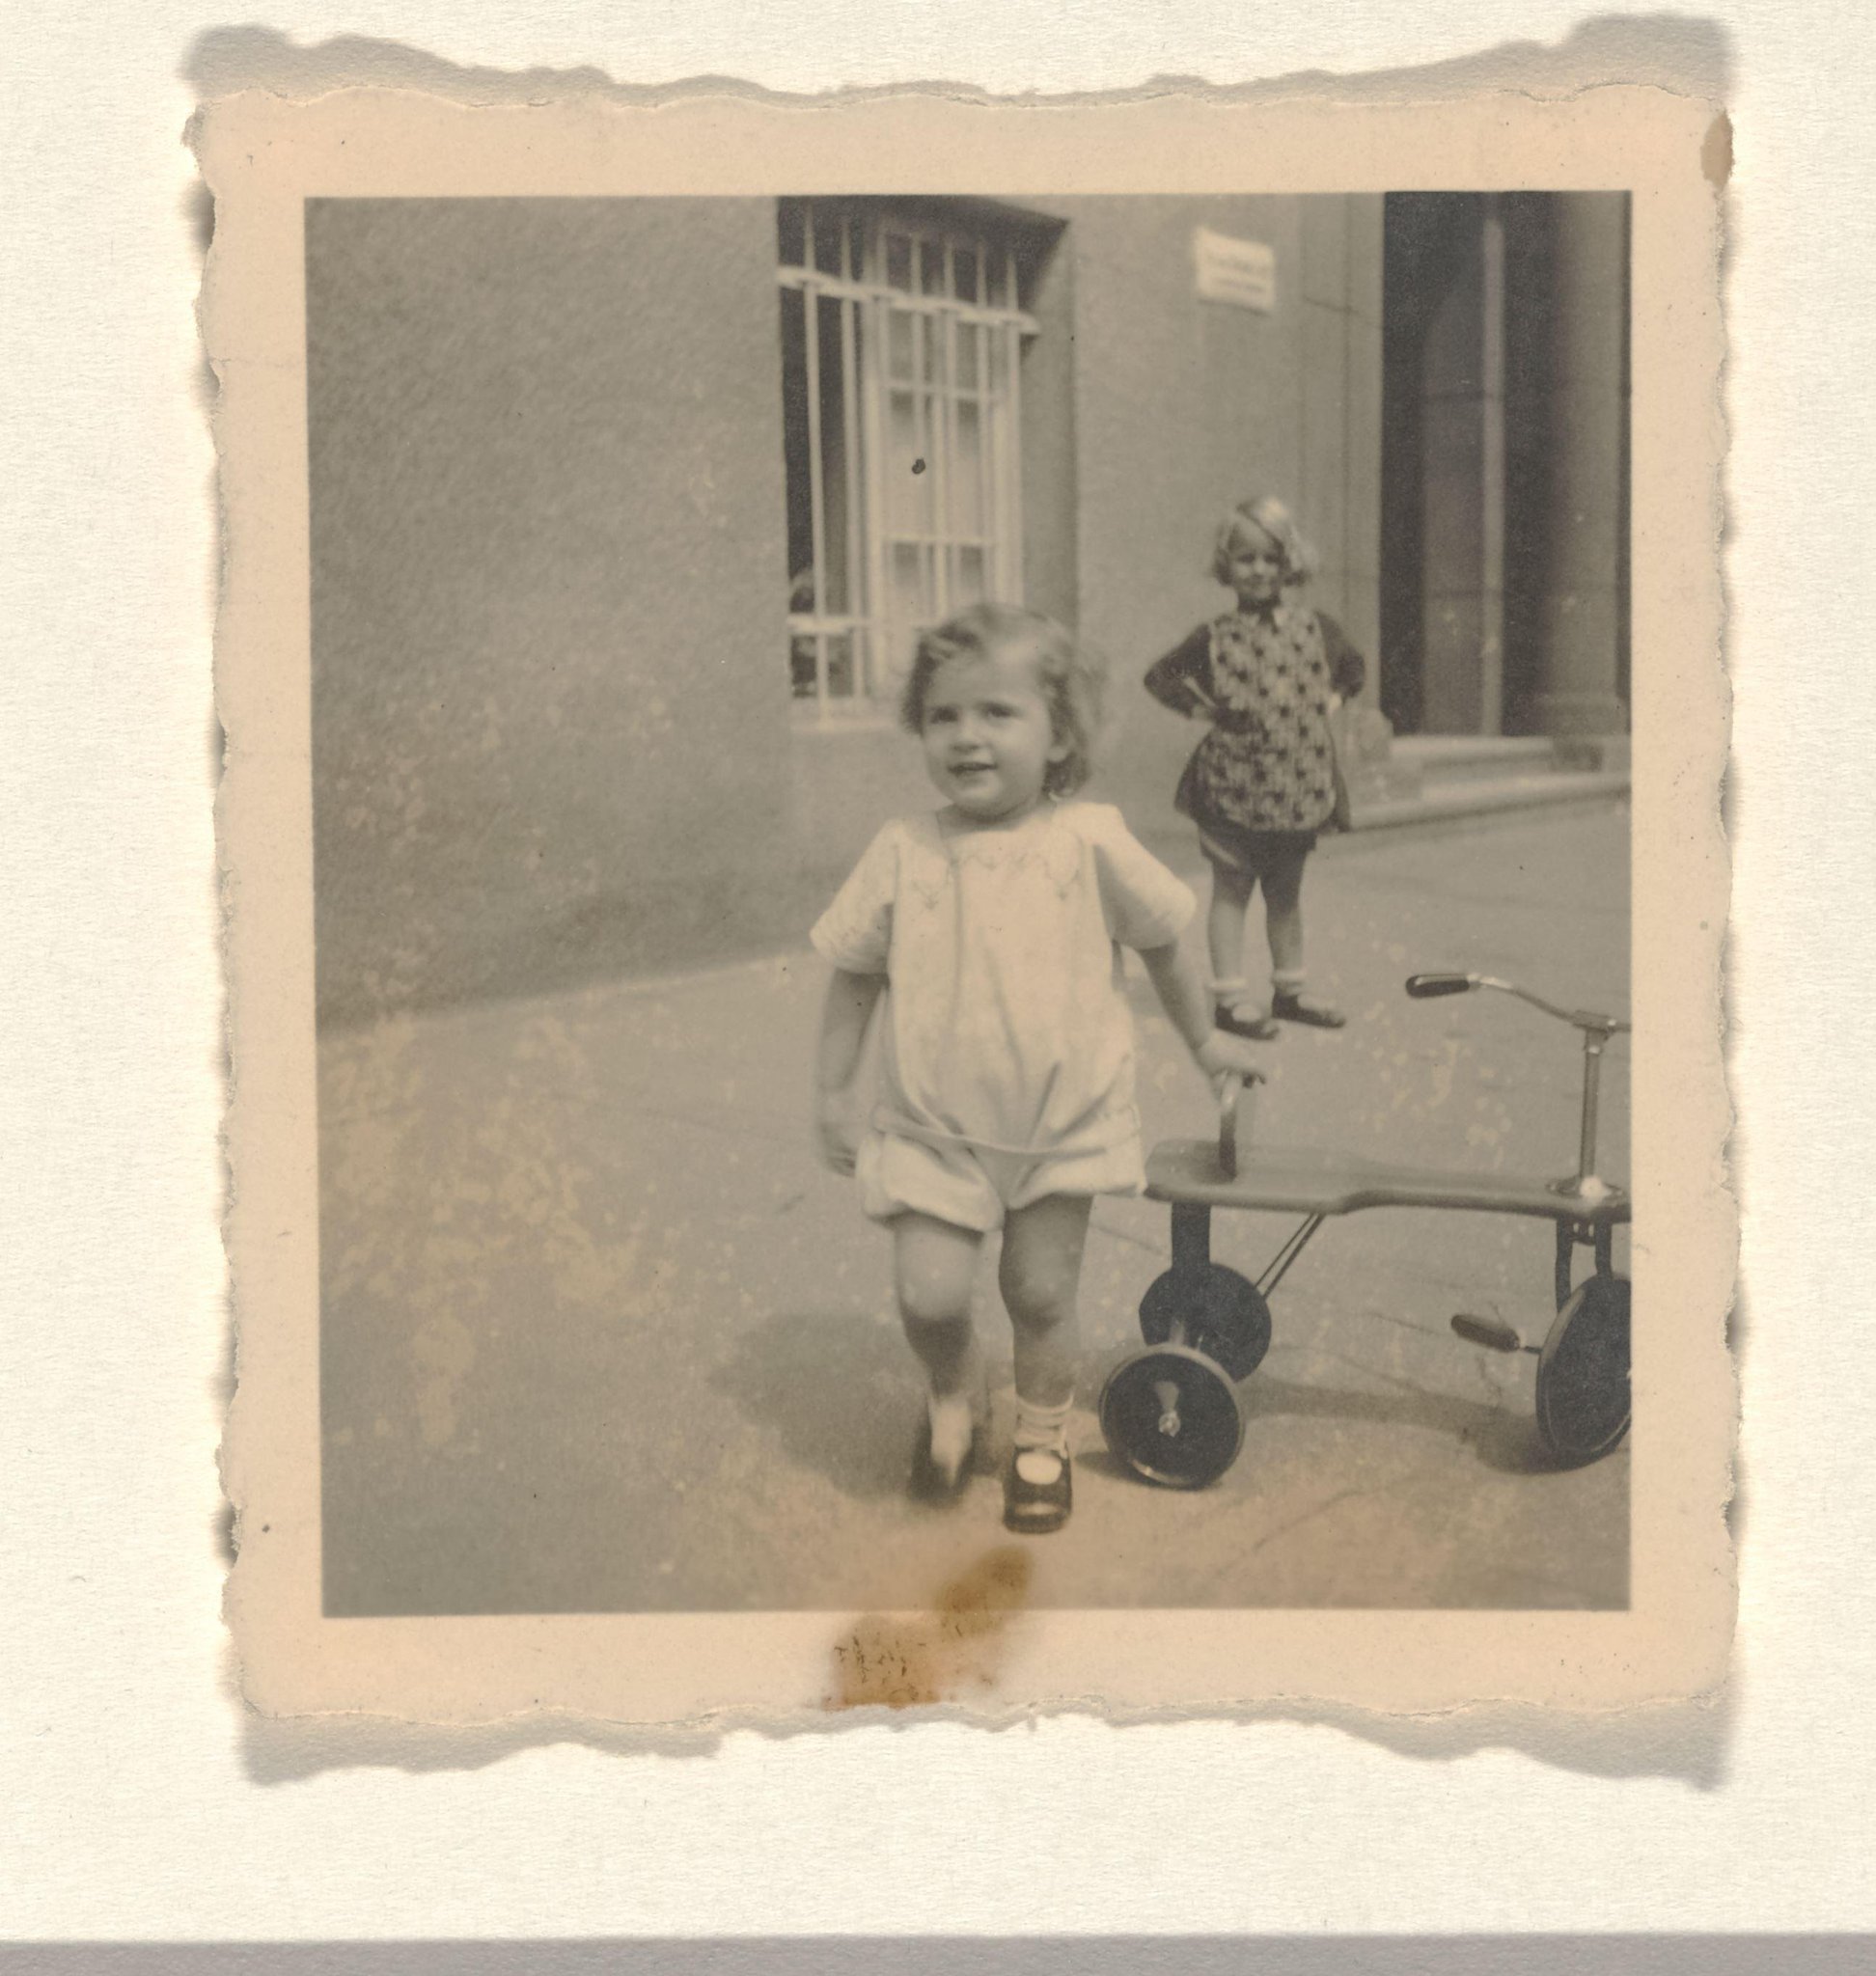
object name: photograph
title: Isabel Wachenheimer in München, midden mei 1929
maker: Anonymous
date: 1905-1929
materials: photographic support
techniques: gelatin silver print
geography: munich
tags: leiden, isabel wachenheimer-elon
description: Dit object is onderdeel van de nalatenschap van Isabel Elon-Wachenheimer (1928-2010). Tot haar overlijden behoorde het samen met de andere objecten uit de nalatenschap tot haar privédomein van Isabel Wachenheimer. In die particuliere context zijn deze objecten tezamen en individueel aandenkens - aan de jeugd, ouders en familie van Isabel Wachenheimer vóór en tijdens de Shoah en aan haar leven na de Tweede Wereldoorlog. Isabel Wachenheimer, die van juni 1943 tot mei 1945 gevangen zat in Kamp Westerbork, Theresienstadt, Auschwitz, Lenzing a/d Oberdonau (een buitenkamp van Mauthausen), overleefde de Shoah. Haar ouders – Eugène Wachenheimer en Else Wachenheimer-Moos - werden op 14 oktober 1944 in Auschwitz-Birkenau vermoord.